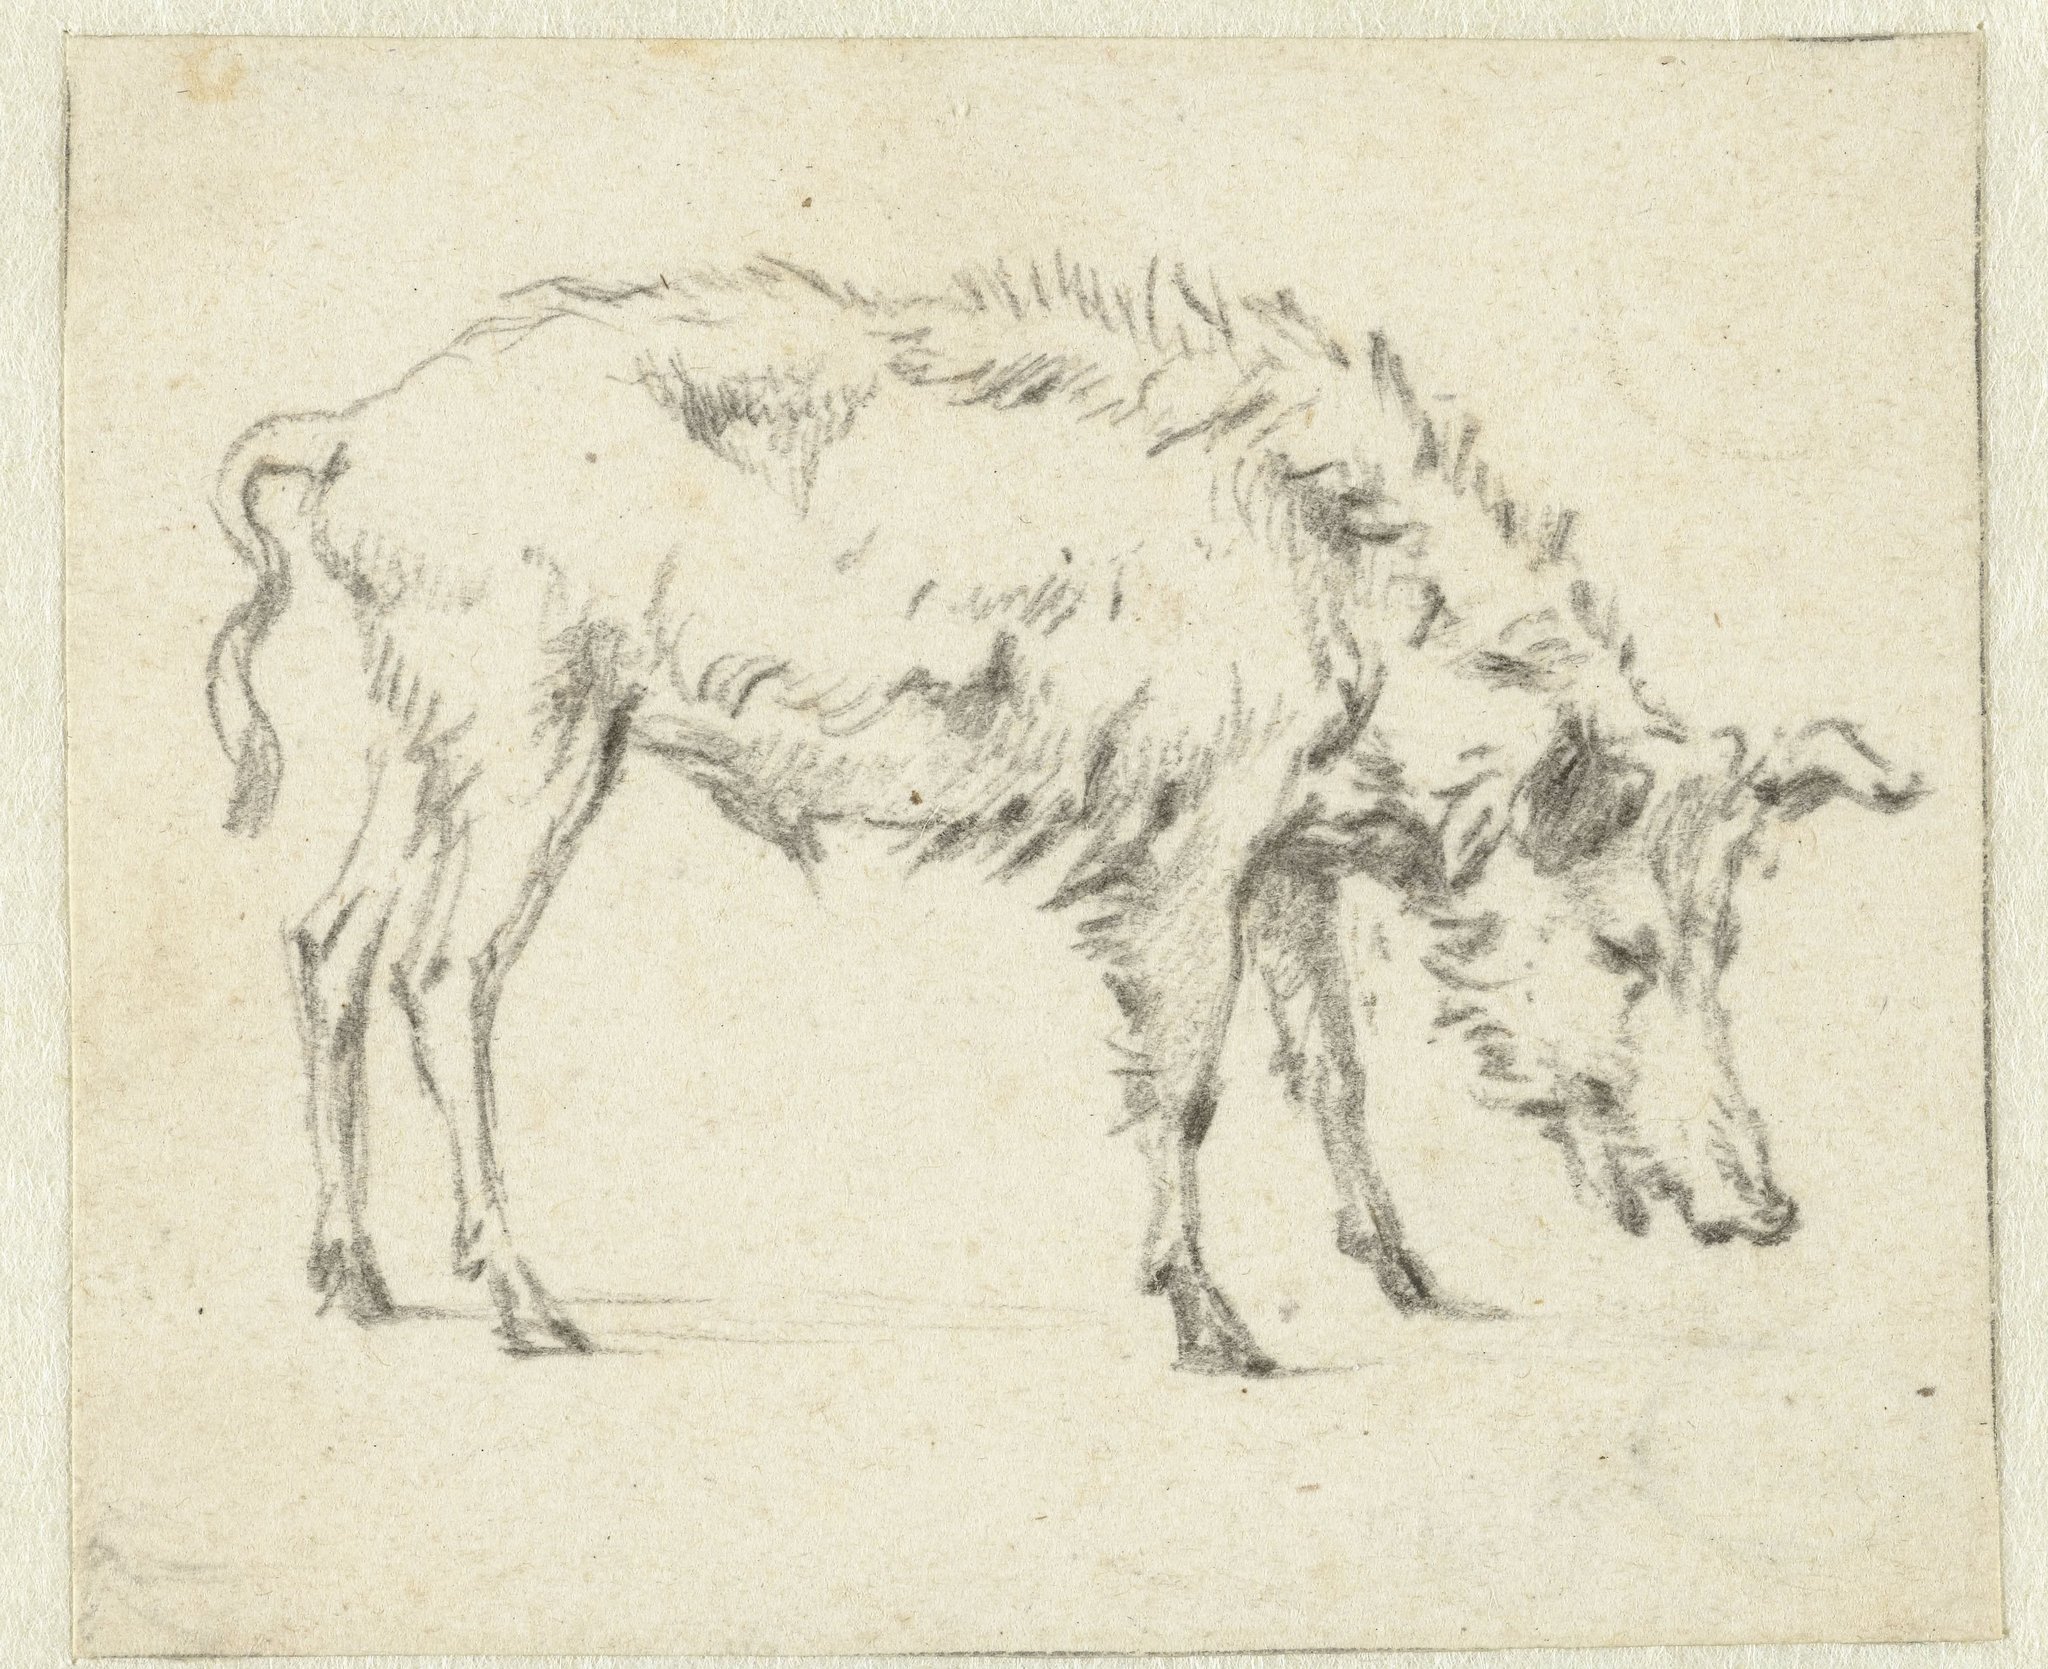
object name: drawing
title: Varken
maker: karel du jardin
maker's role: draughtsman, painter, print maker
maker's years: 1626-1678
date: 1632-1678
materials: chalk, paper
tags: pig